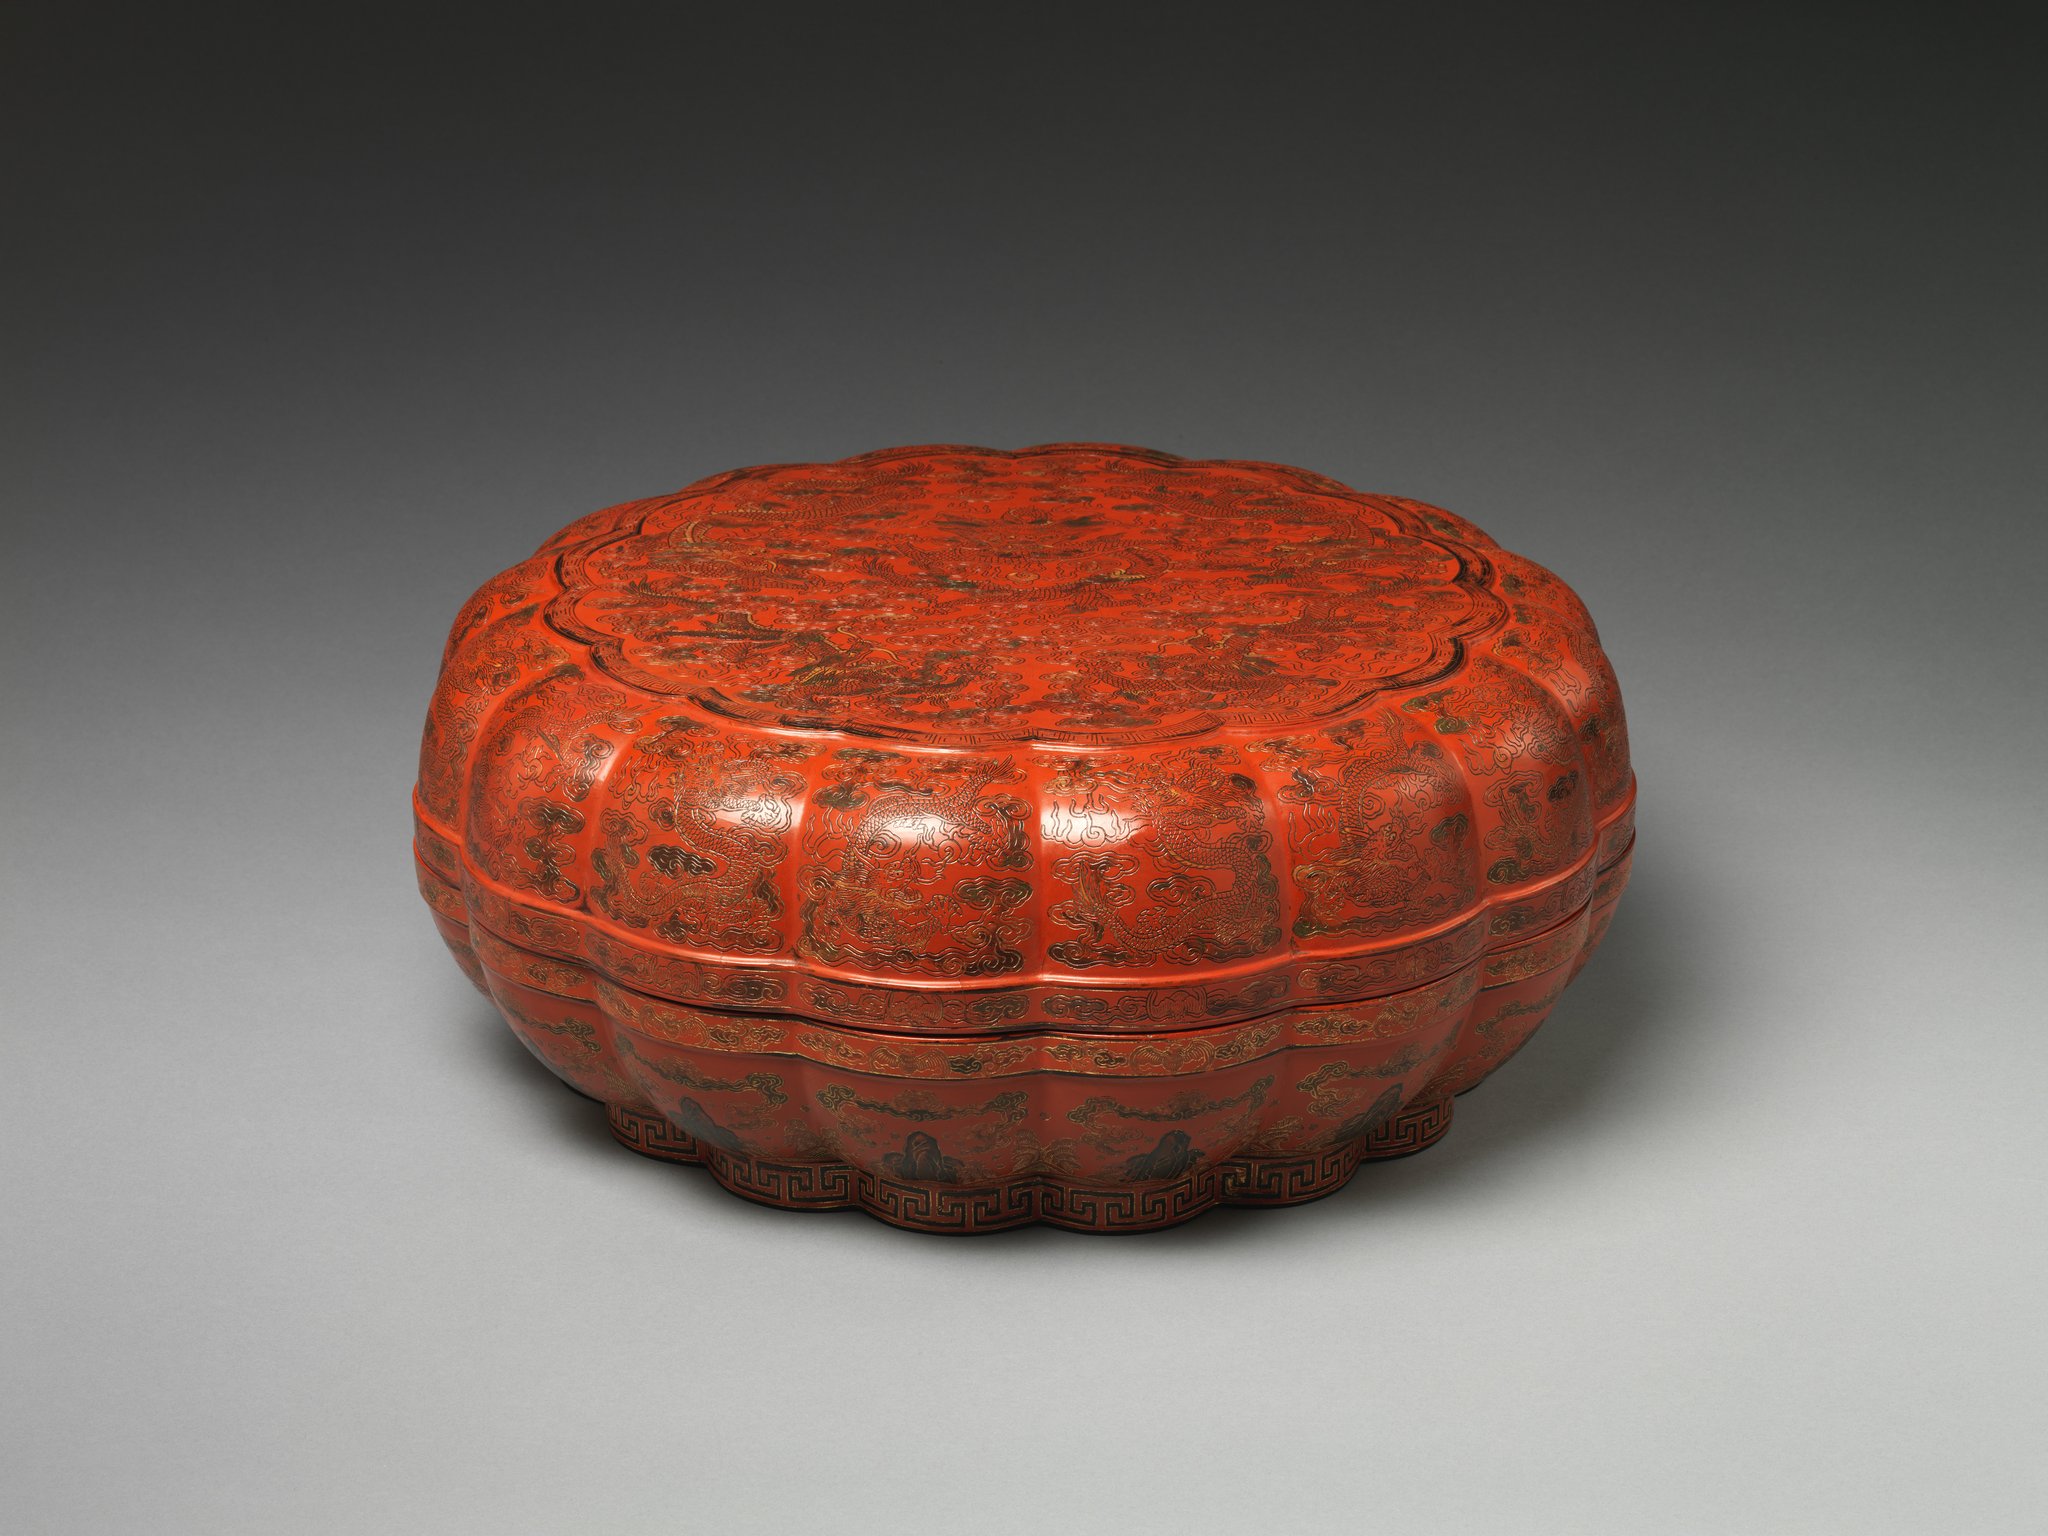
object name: lobed box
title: Sixteen-lobed box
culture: chinese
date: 1736-1795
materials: gold, lacquer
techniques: engraving, polychrome